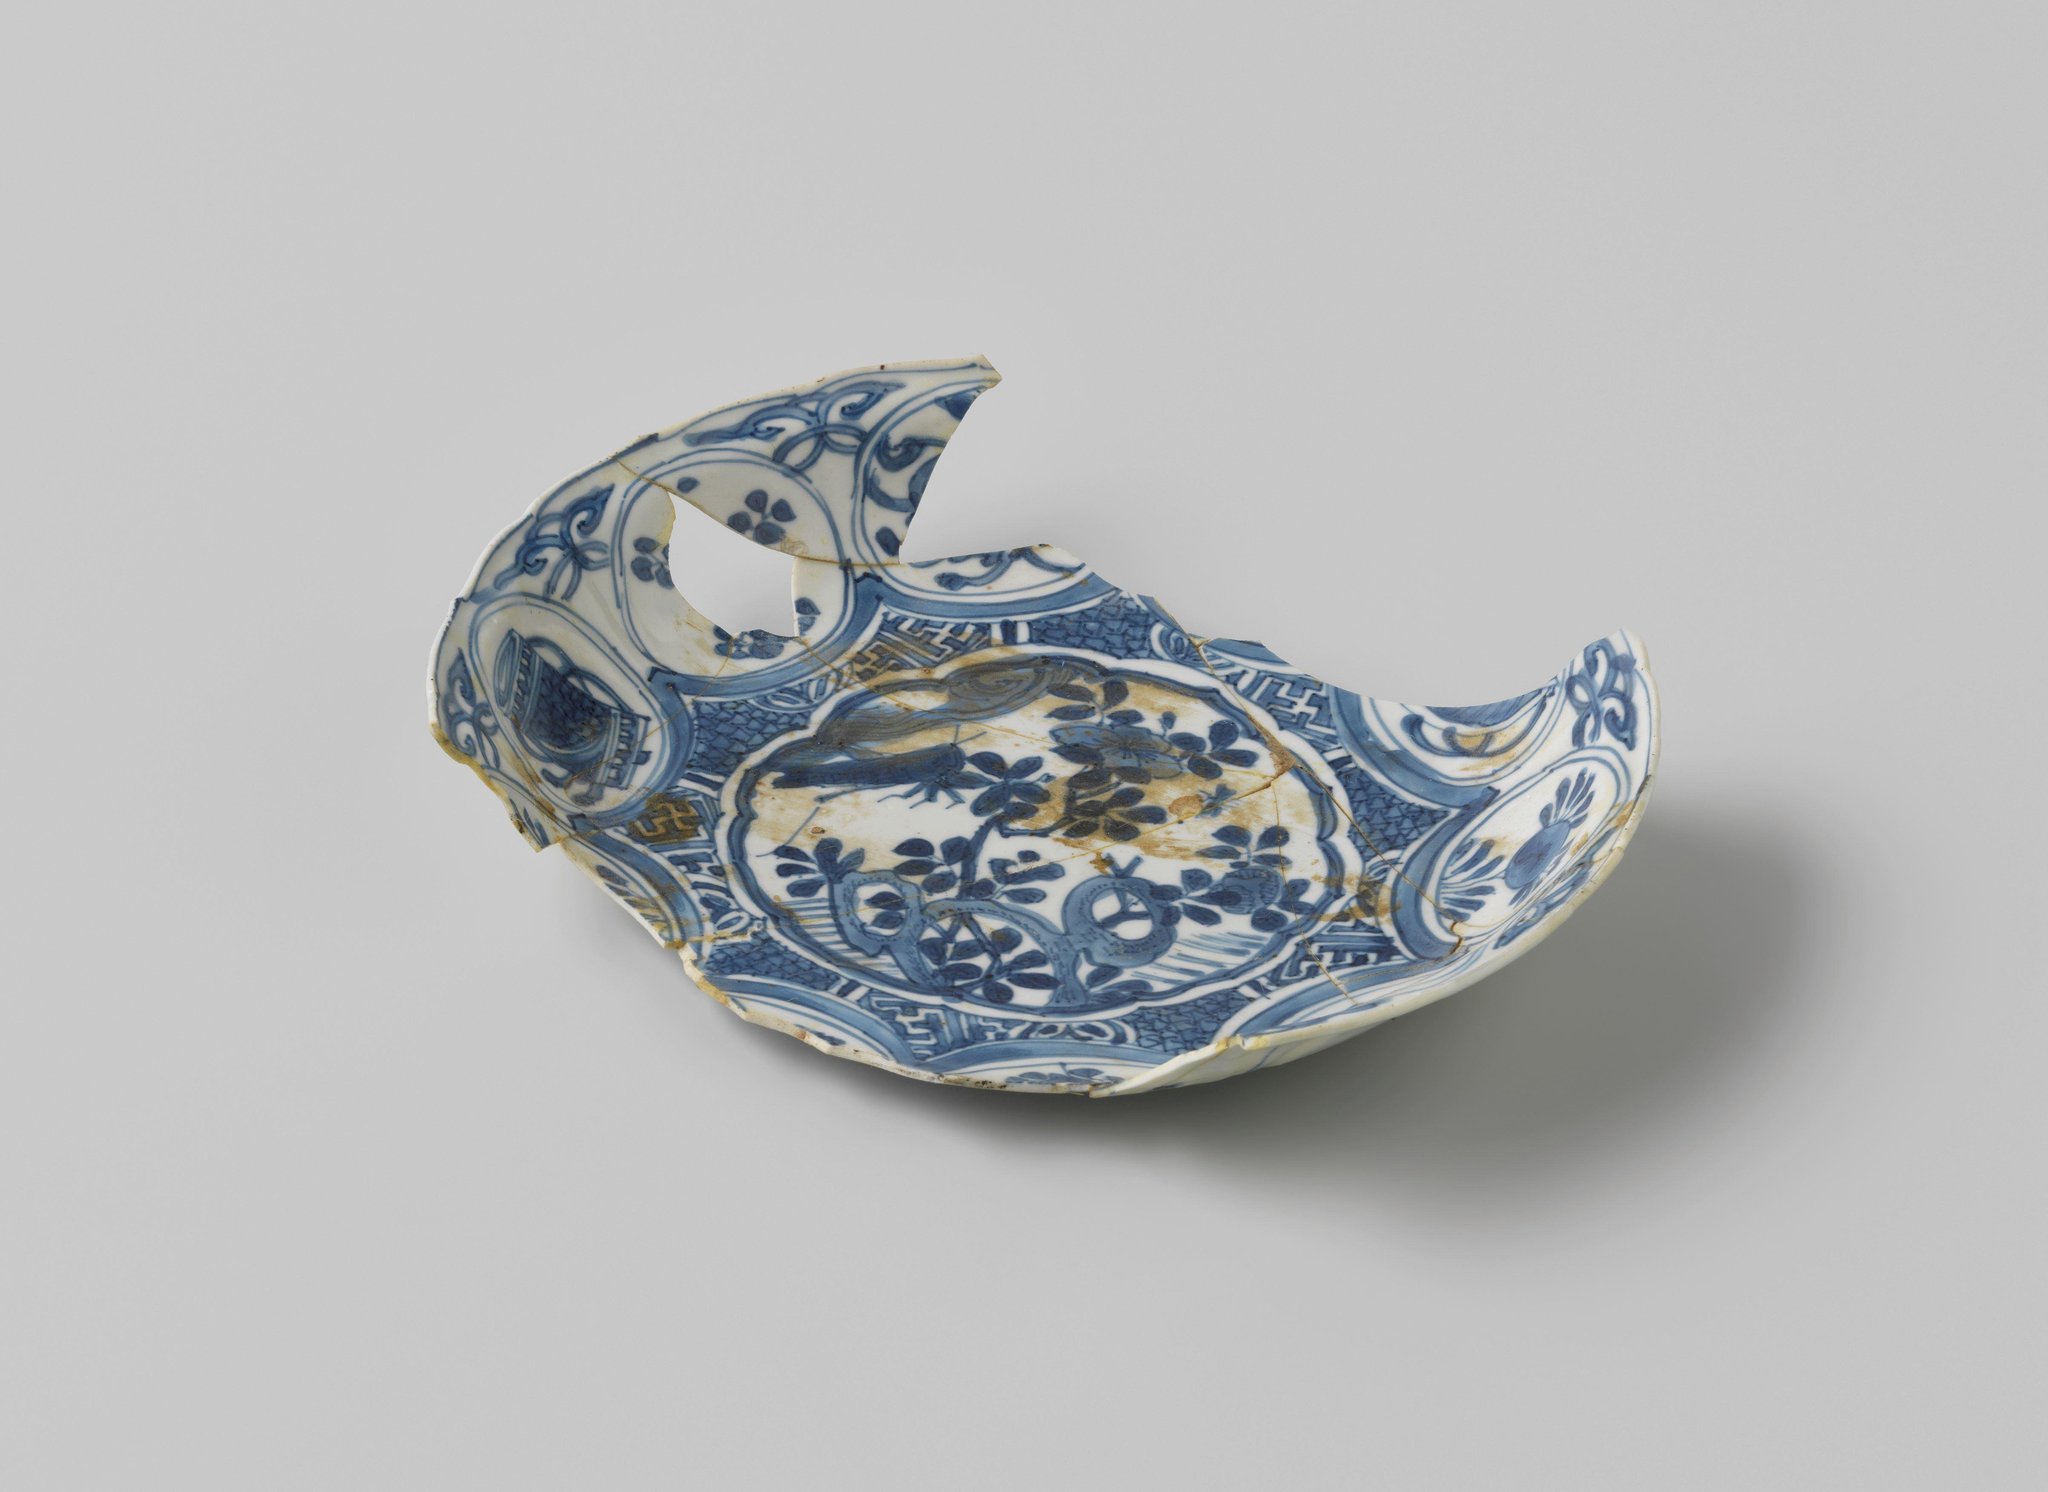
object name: sherd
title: Fragment bord uit V.O.C.-schip de 'Witte Leeuw'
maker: Anonymous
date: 1613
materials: bone china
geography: jingdezhen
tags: verenigde oostindische compagnie, sint-helena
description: A dish without a flattened rim. A scalloped medallion with rui heads alternating with radial panels within a star-shaped medallion, filled with various diaper patterns. A central decoration of a grasshopper above a flower on a rock. The medallions decorated with alternately a flower or peach and a symbol.